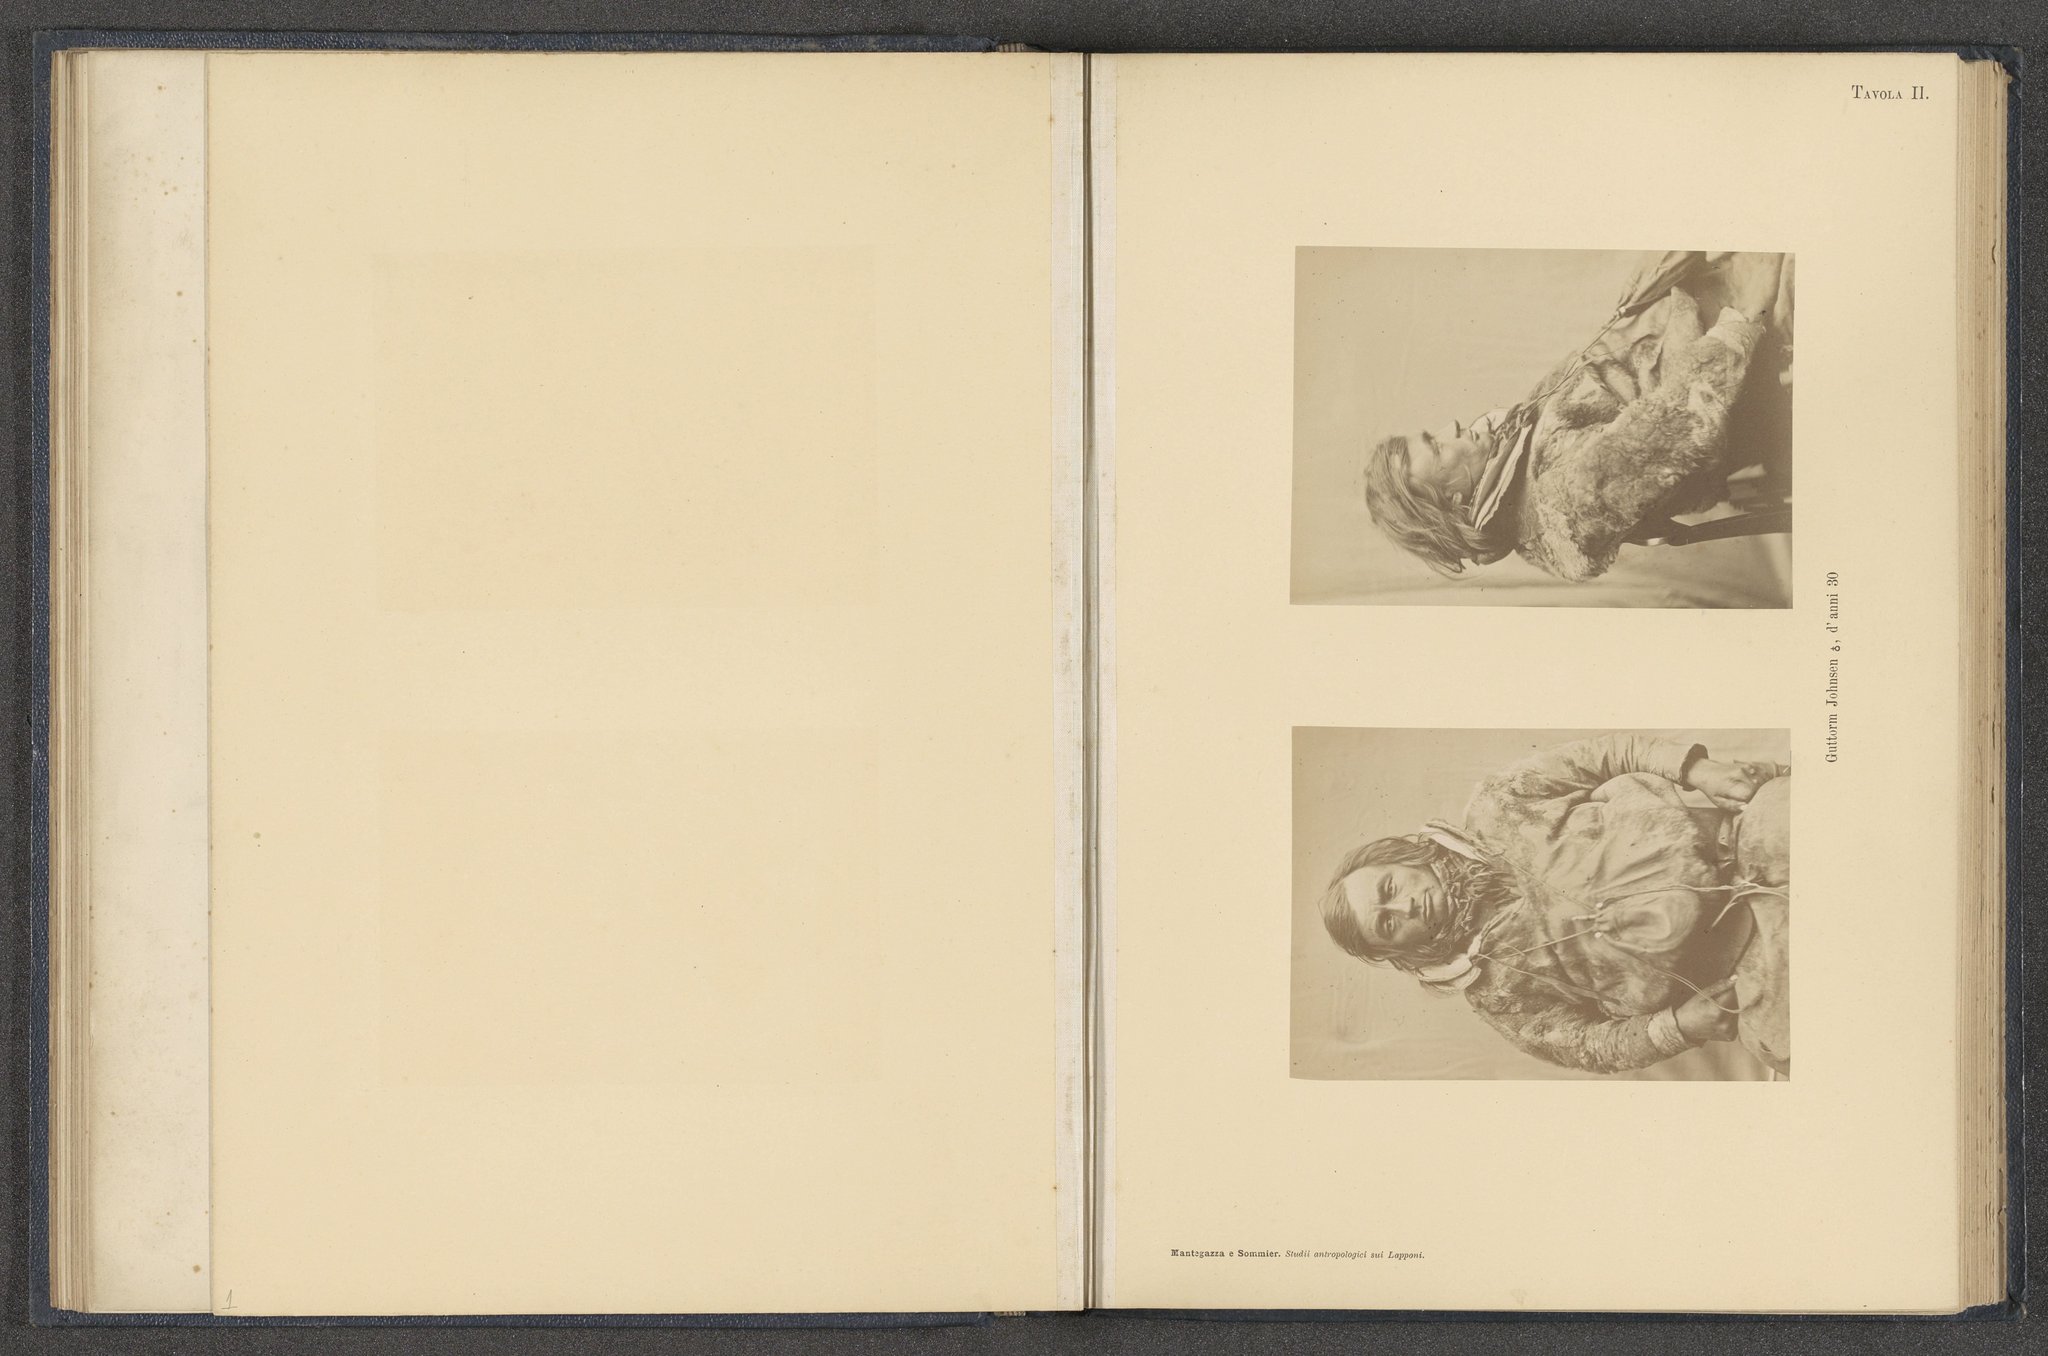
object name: page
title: Guttorm Johnsen ♂, d' anni 30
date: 1870-1880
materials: paper, photographic support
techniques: albumen print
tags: adult man (+ front view), adult man (+ sideview, profile), fashion, clothing (+ fur used for clothes)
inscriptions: number: ‘Tavola II.’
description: Links een vooraanzicht, rechts een zijaanzicht.